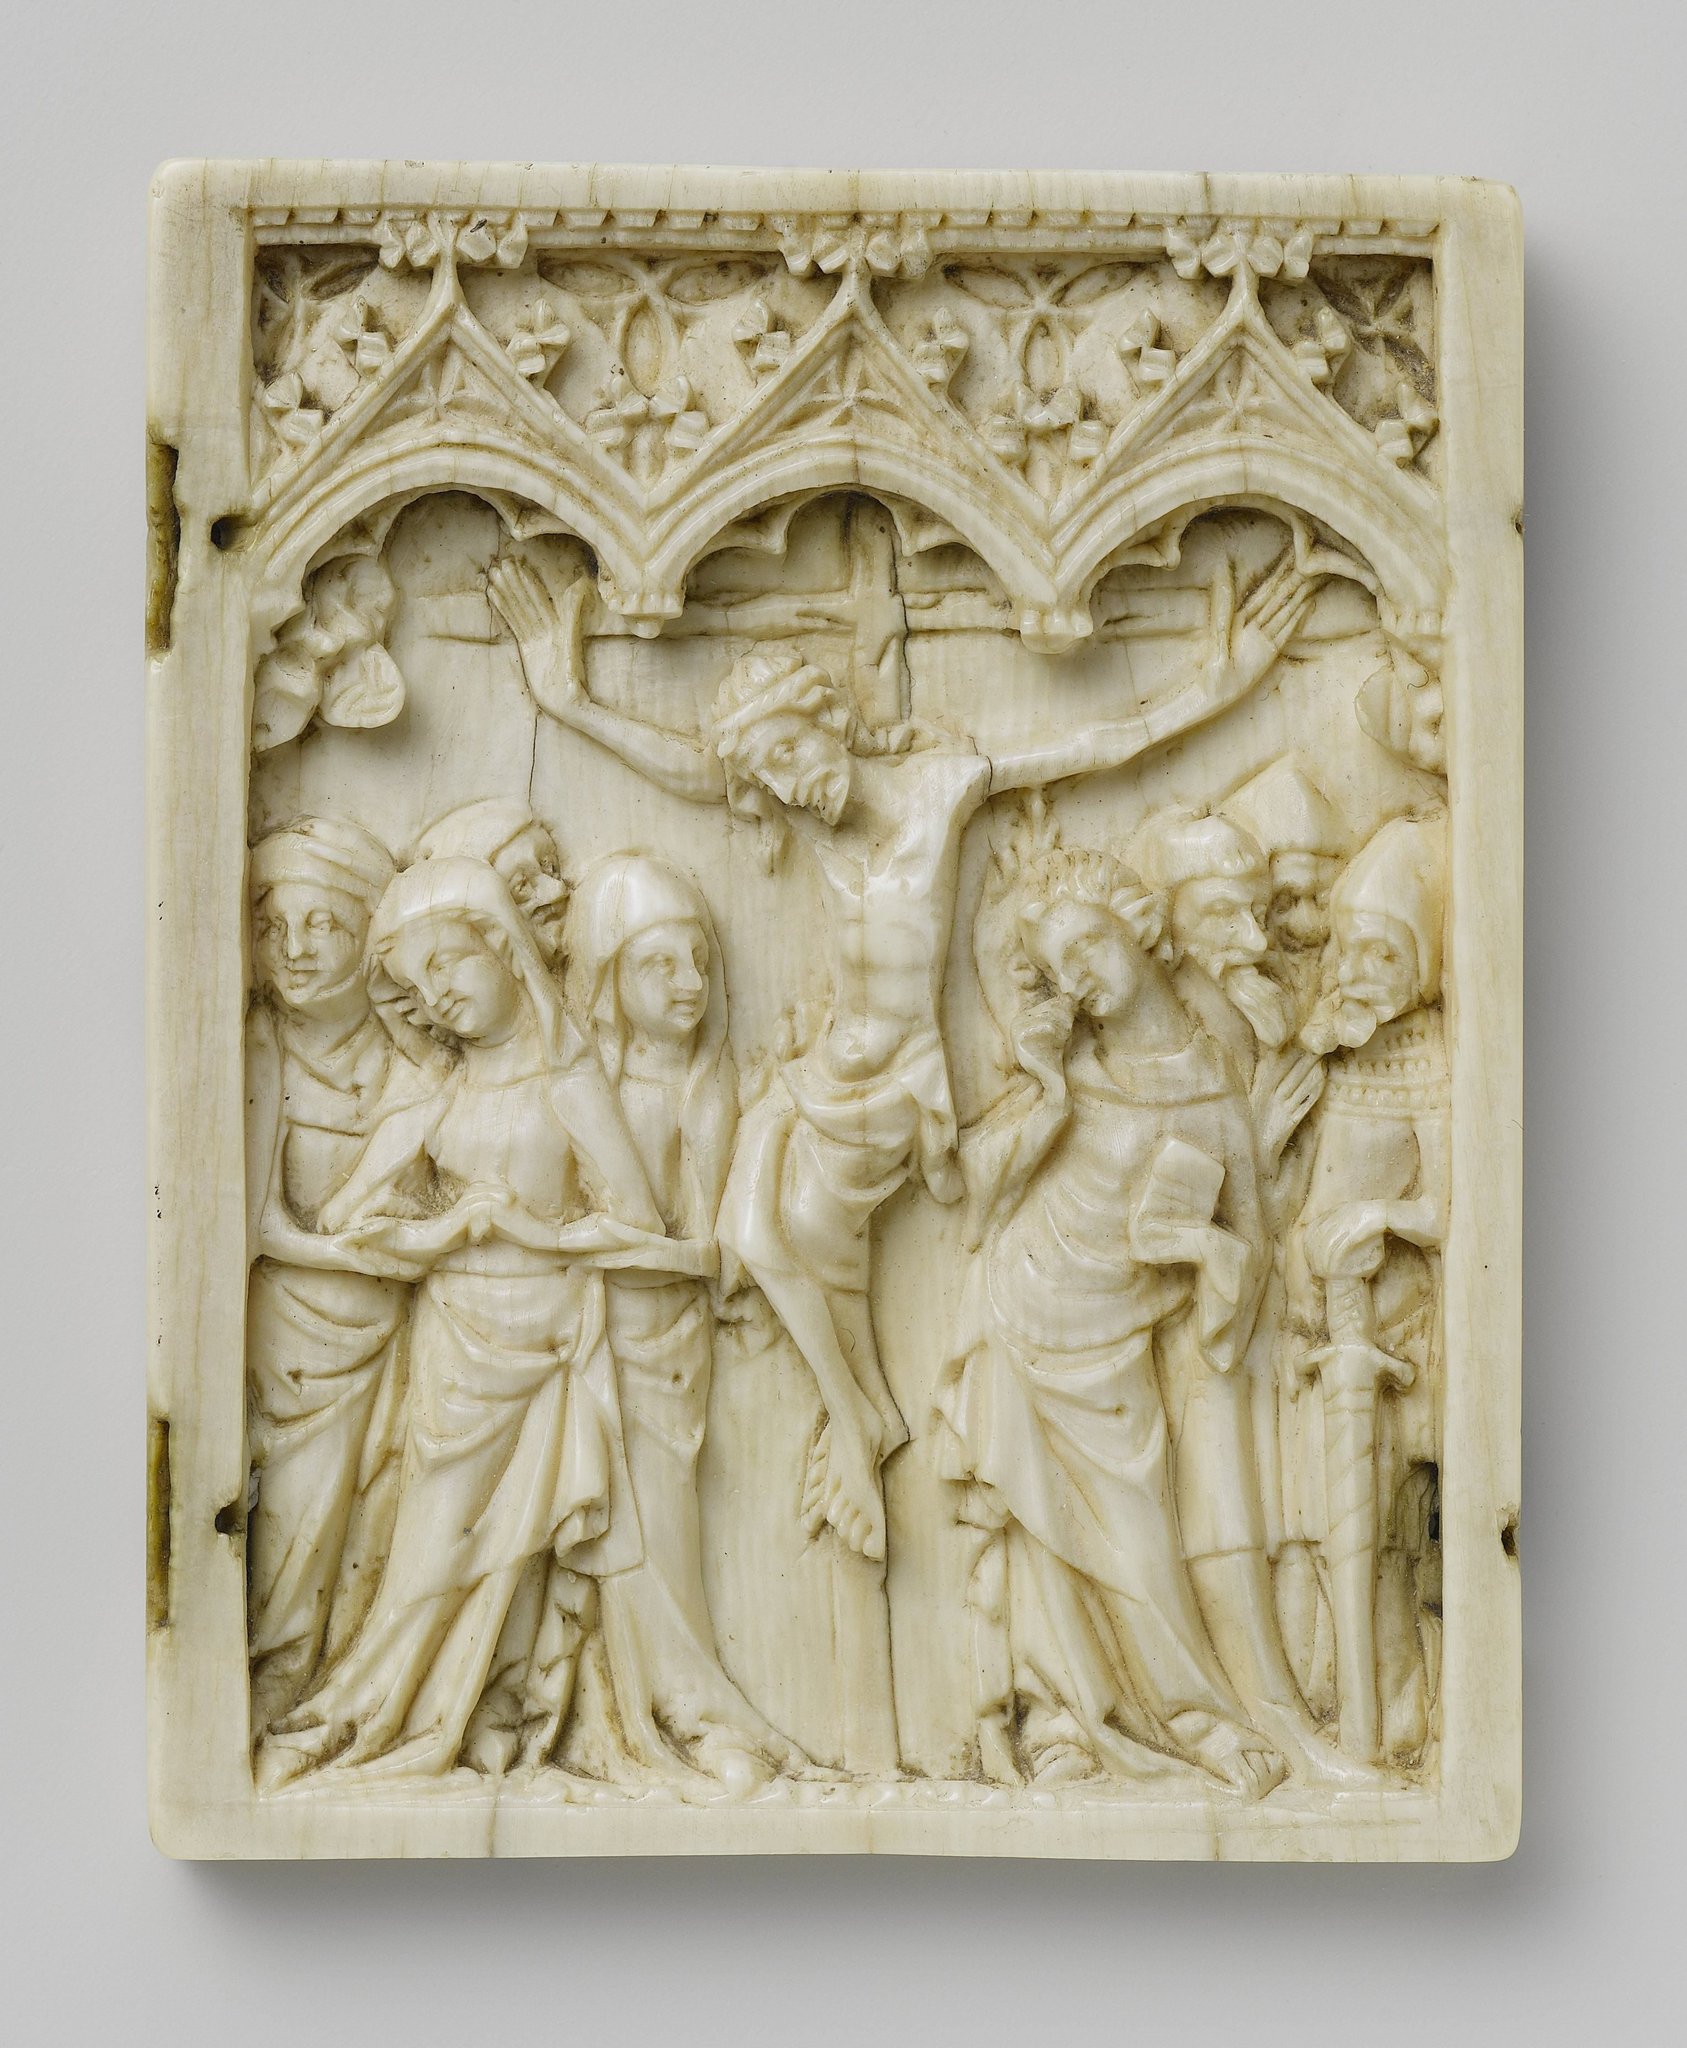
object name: polyptych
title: Right wing of a polyptych with the Crucifixion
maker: Anonymous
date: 1375-1400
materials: ivory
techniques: cutting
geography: ile-de-france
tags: bystanders at the foot of the cross, among whom mary, mary magdalene and john the evangelist; mary may be shown swooning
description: Onder een drietal gotische driepasbogen hangt Christus aan het kruis met links Maria met drie heilige vrouwen en rechts Johannes naast drie soldaten. Maria wordt door twee vrouwen bij de armen ondersteund. Johannes draagt een boek; een der soldaten wijst naar Christus, een ander houdt een groot slagzwaard vast. Rechts- en linksboven verdwijnen zon en maan.